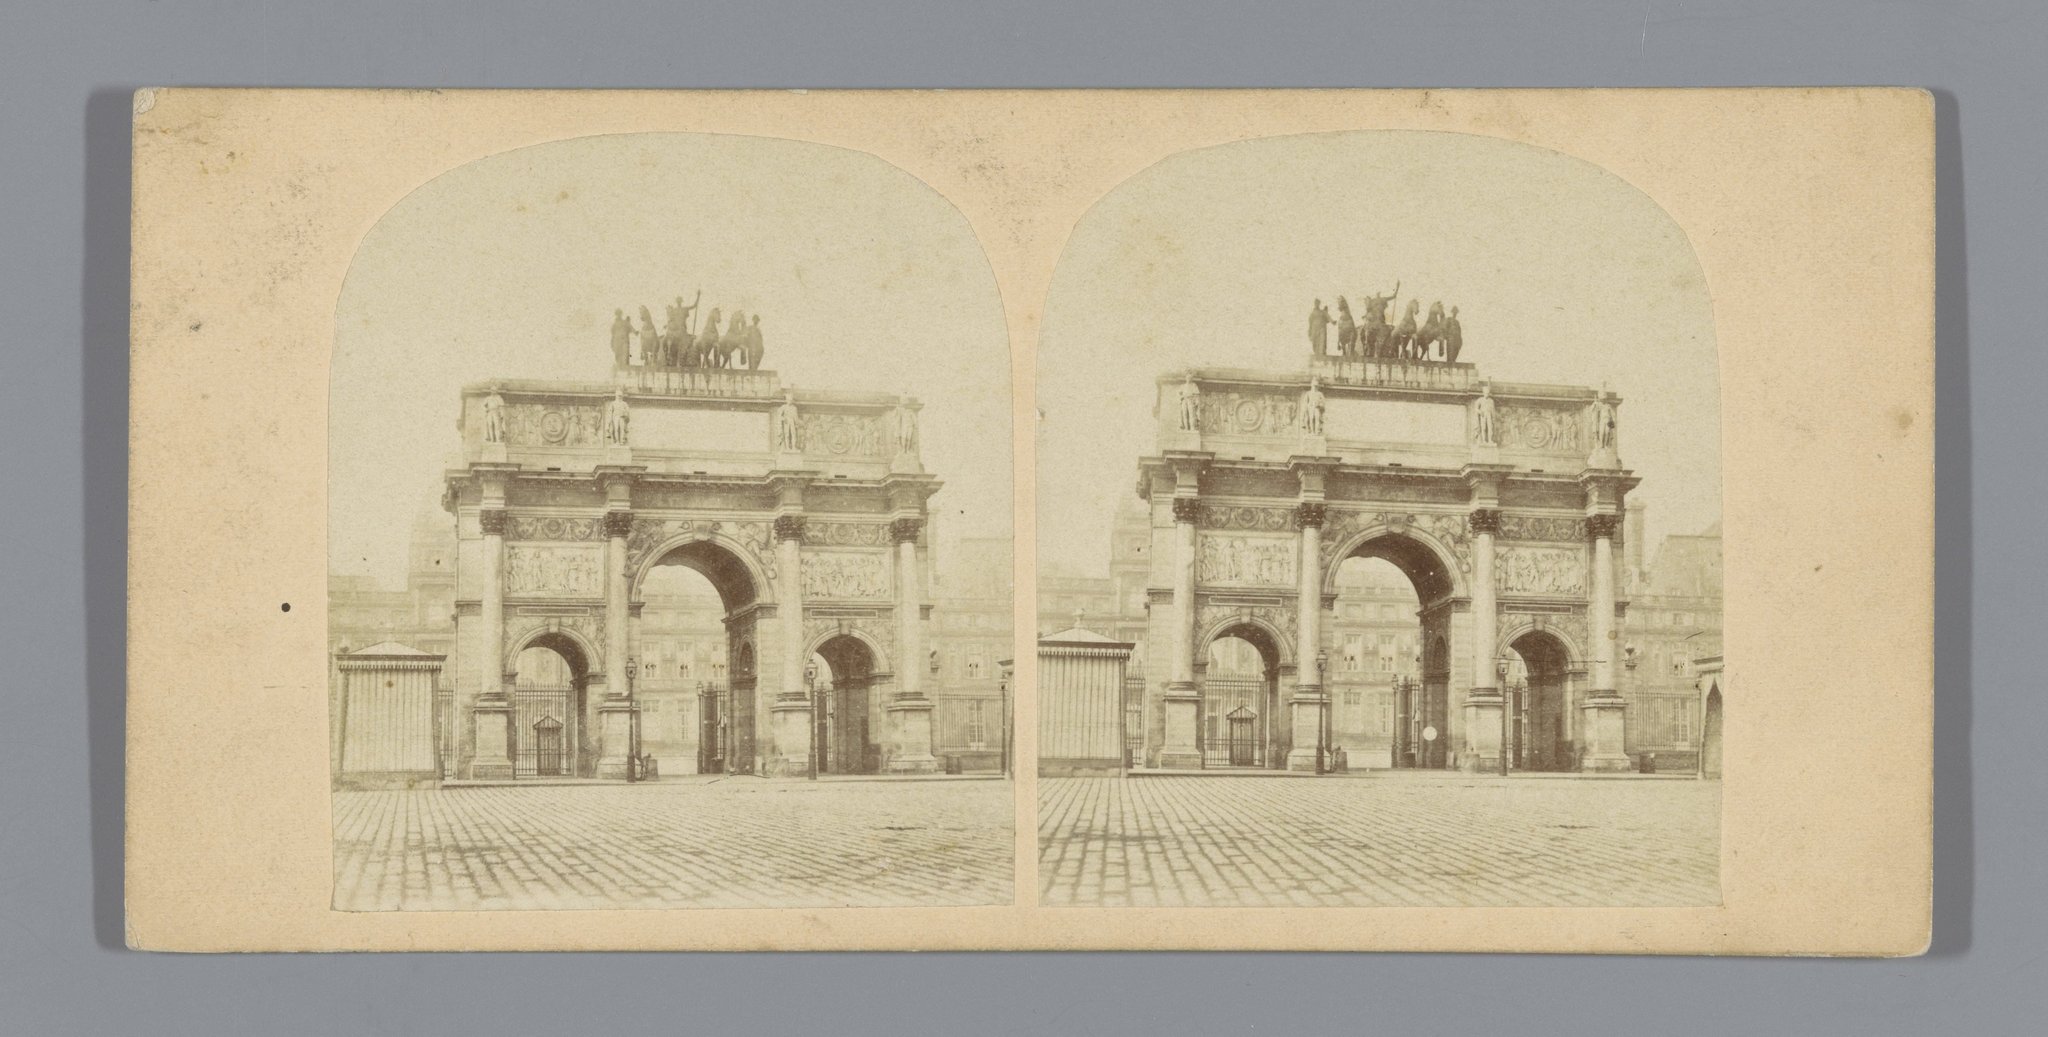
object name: stereograph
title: Arc de Triomphe du Carrousel te Parijs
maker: Anonymous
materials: cardboard, photographic support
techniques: albumen print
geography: place du carrousel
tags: triumphal arch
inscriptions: inscription: ‘Arc du Carrousel’, number: ‘53’